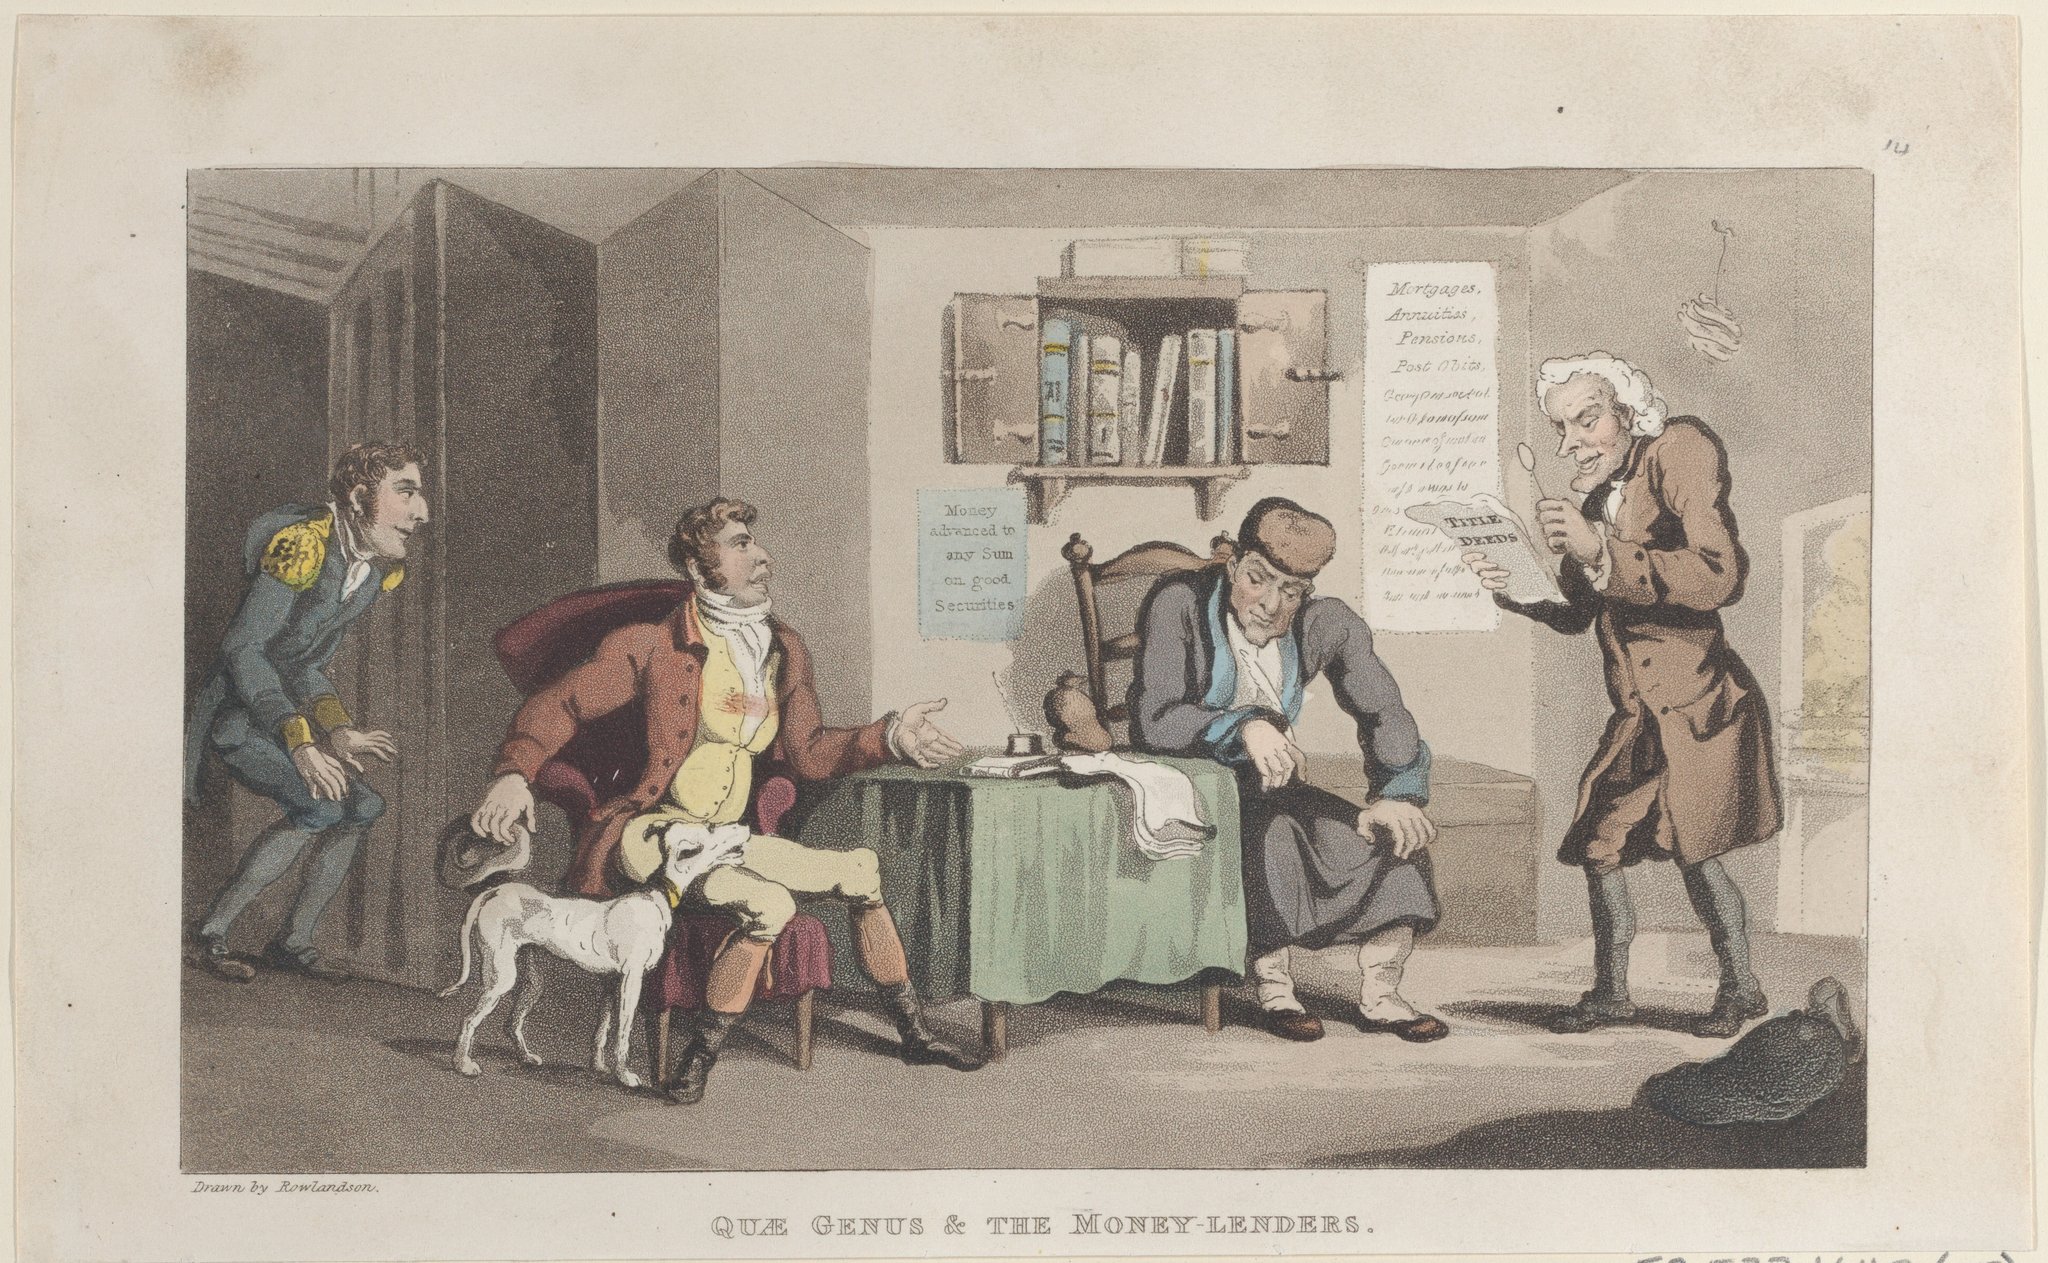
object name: print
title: Quae Genus & The Money Lenders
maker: thomas rowlandson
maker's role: artist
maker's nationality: british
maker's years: 1757-1827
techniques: aquatint, etching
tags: men,dogs